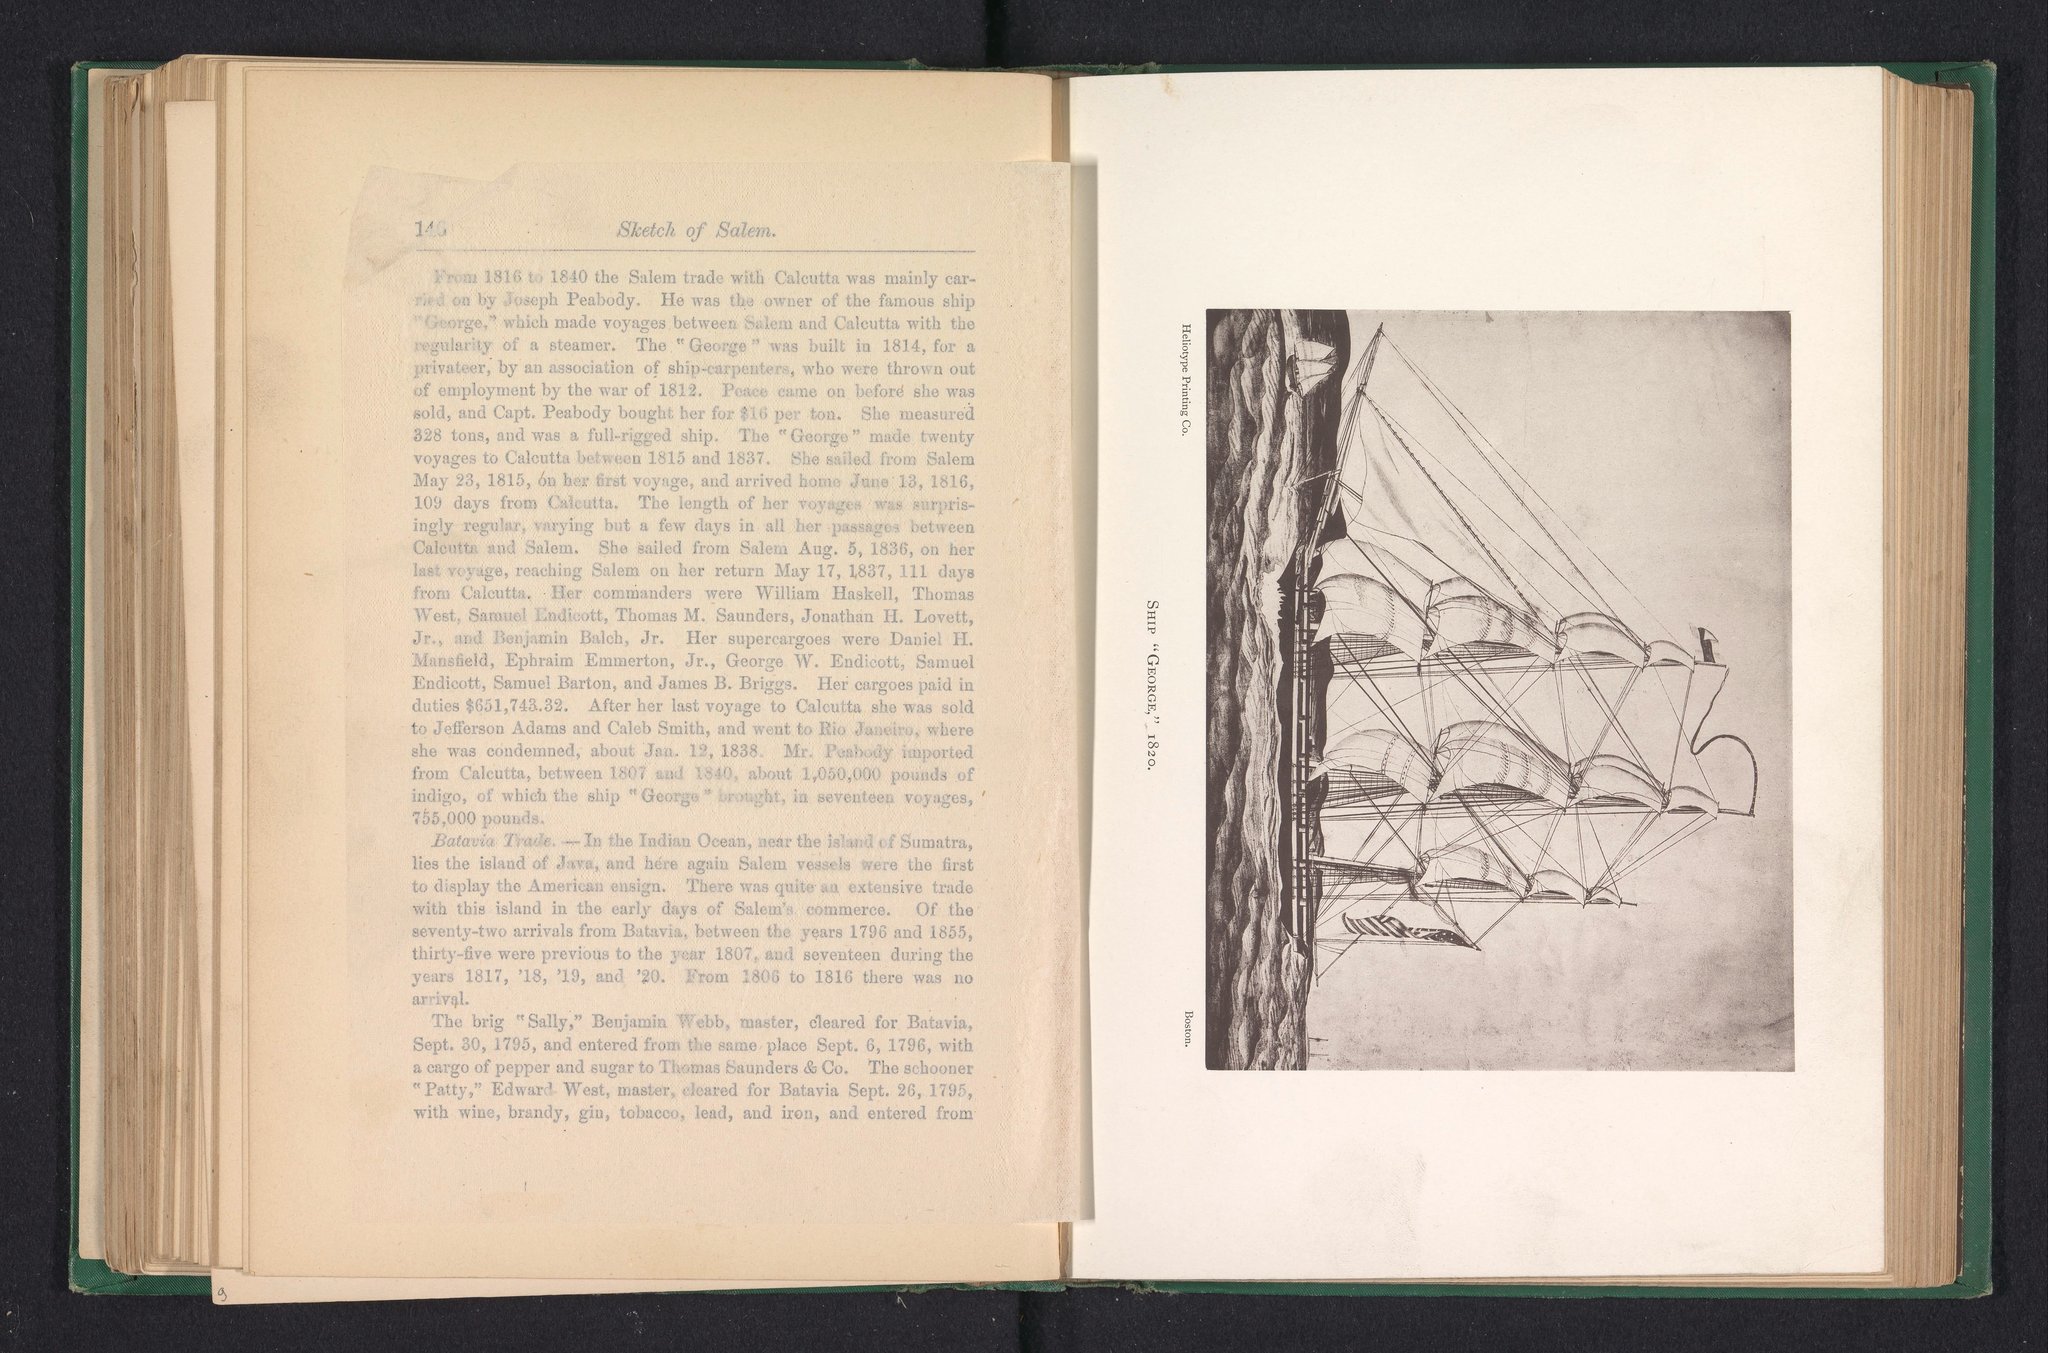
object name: page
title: Fotoreproductie van een tekening van het schip George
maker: Anonymous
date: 1869-1879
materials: paper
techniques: photoaquatint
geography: boston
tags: ships (in general), merchant shipping, shipping trade